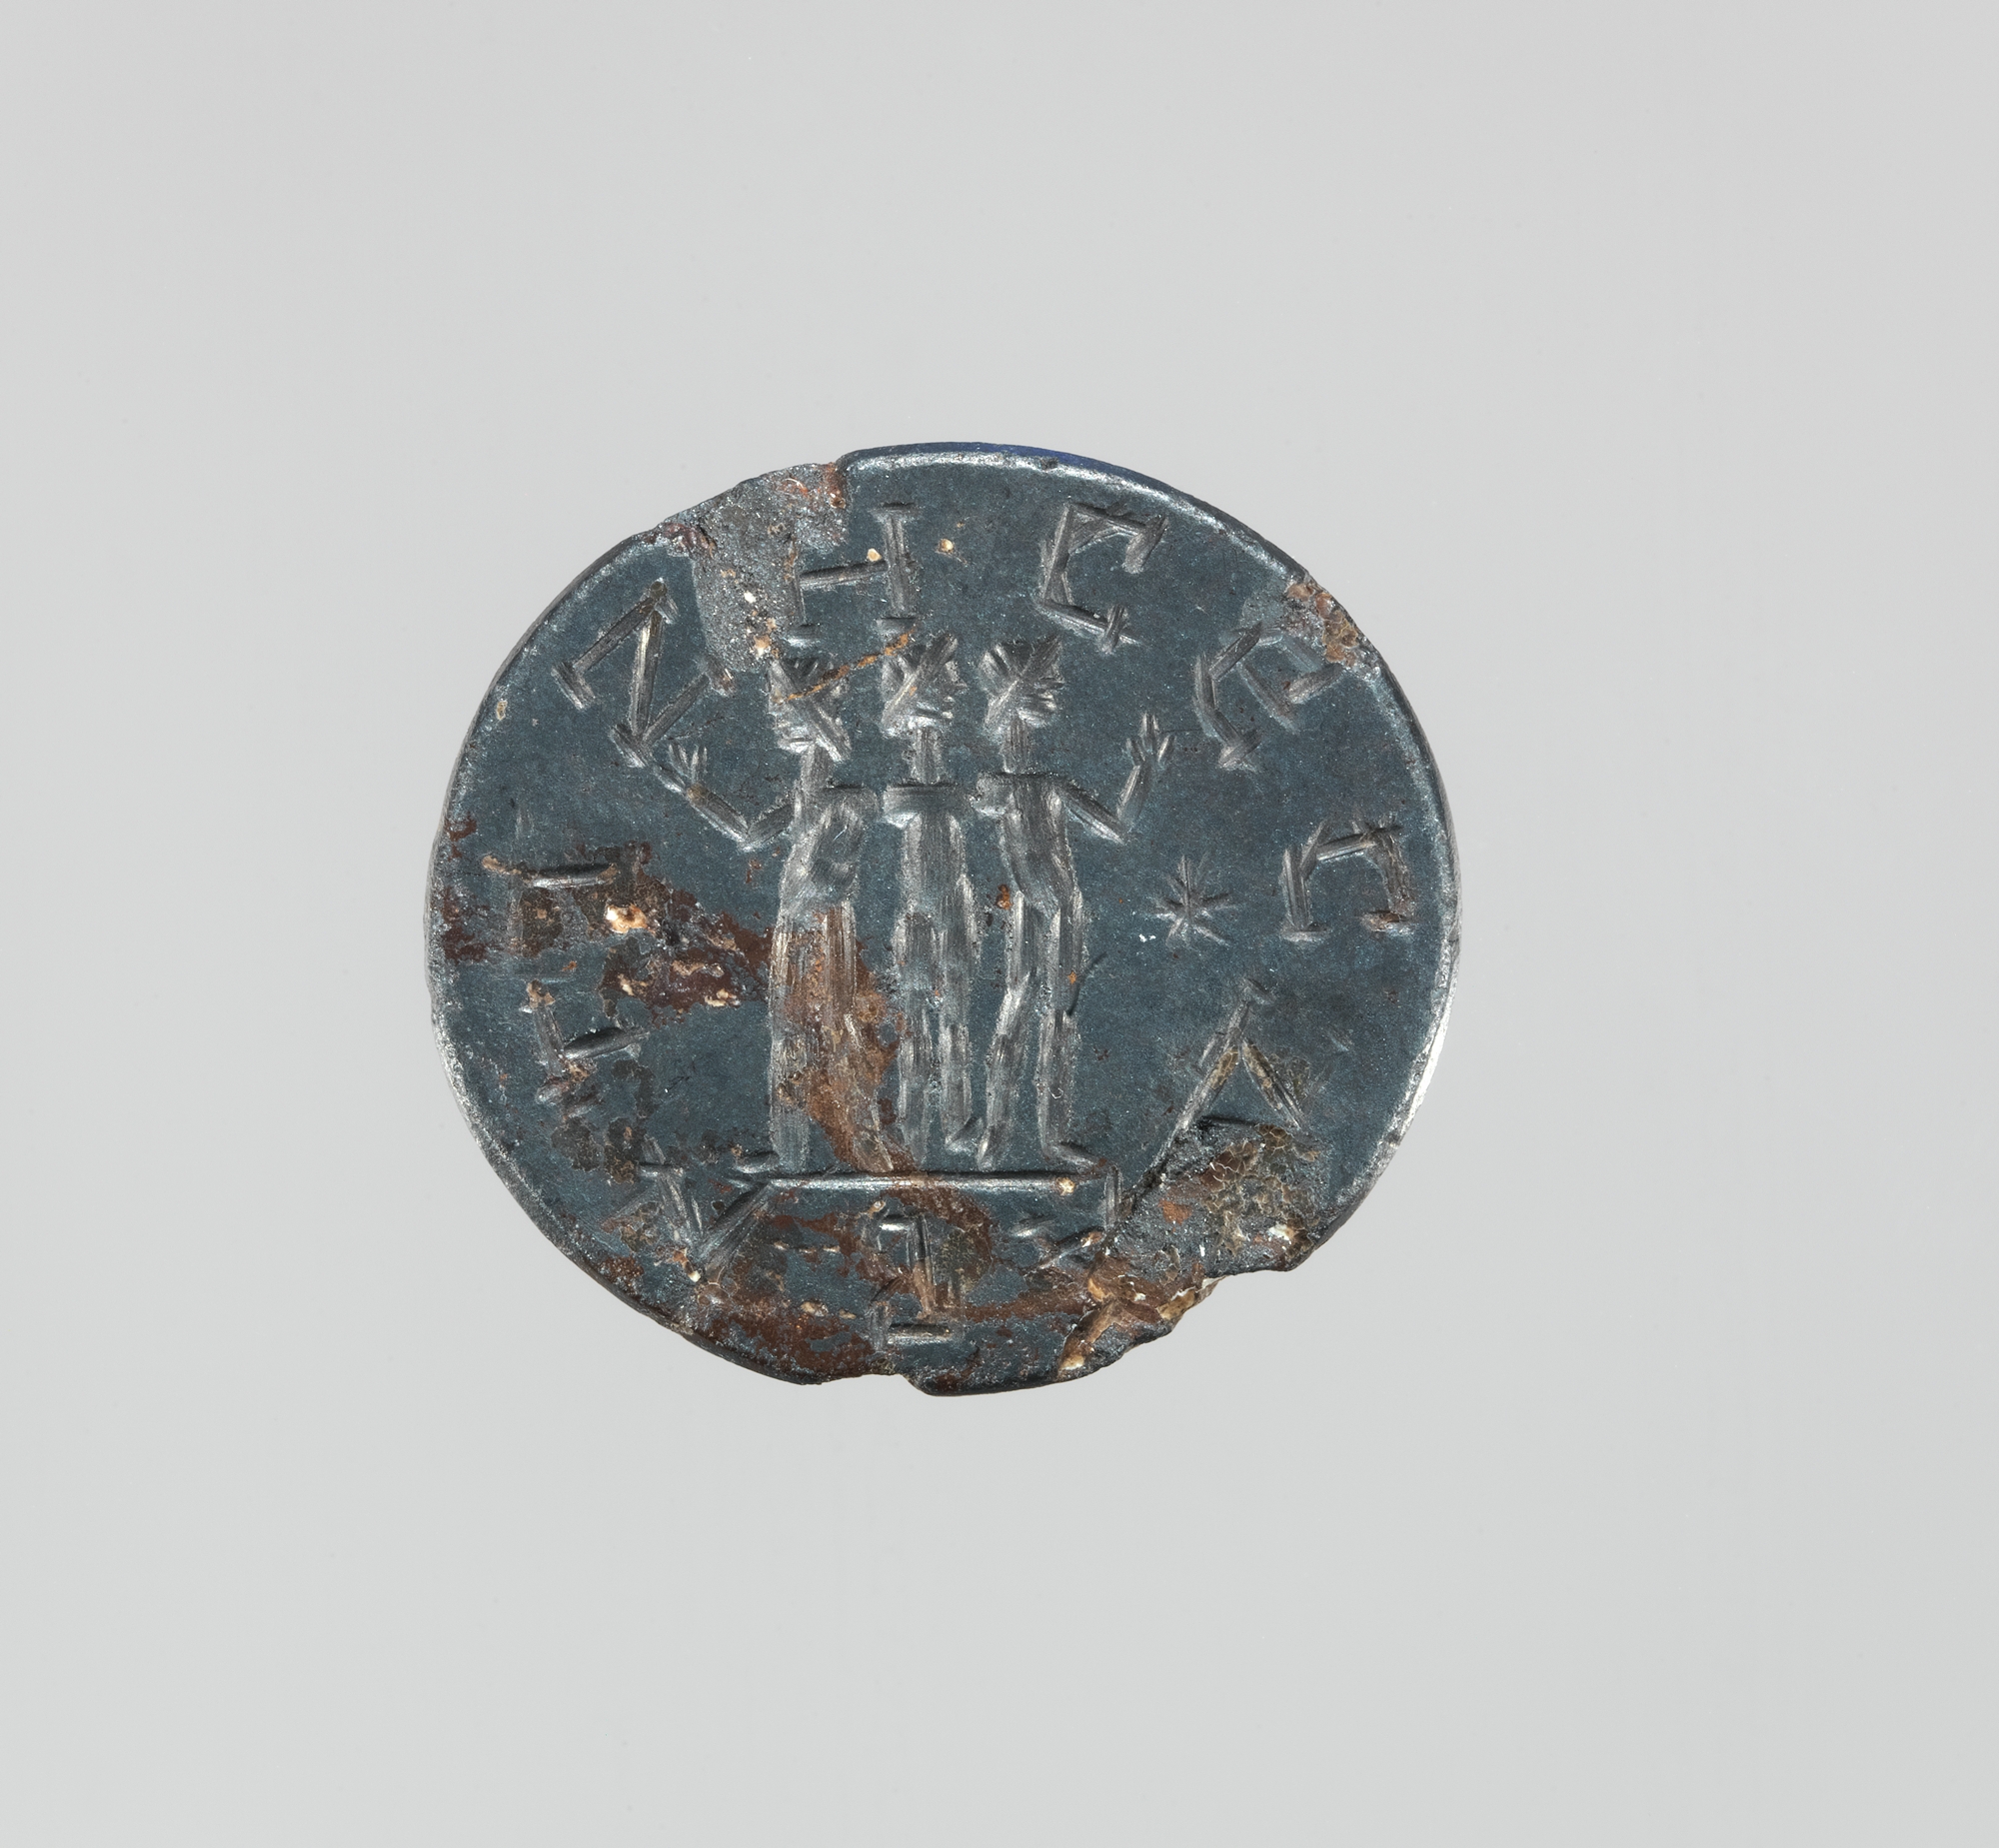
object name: intaglio, magical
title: Jasper intaglio: The Three Graces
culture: roman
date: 101-300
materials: mineral, jasper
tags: women